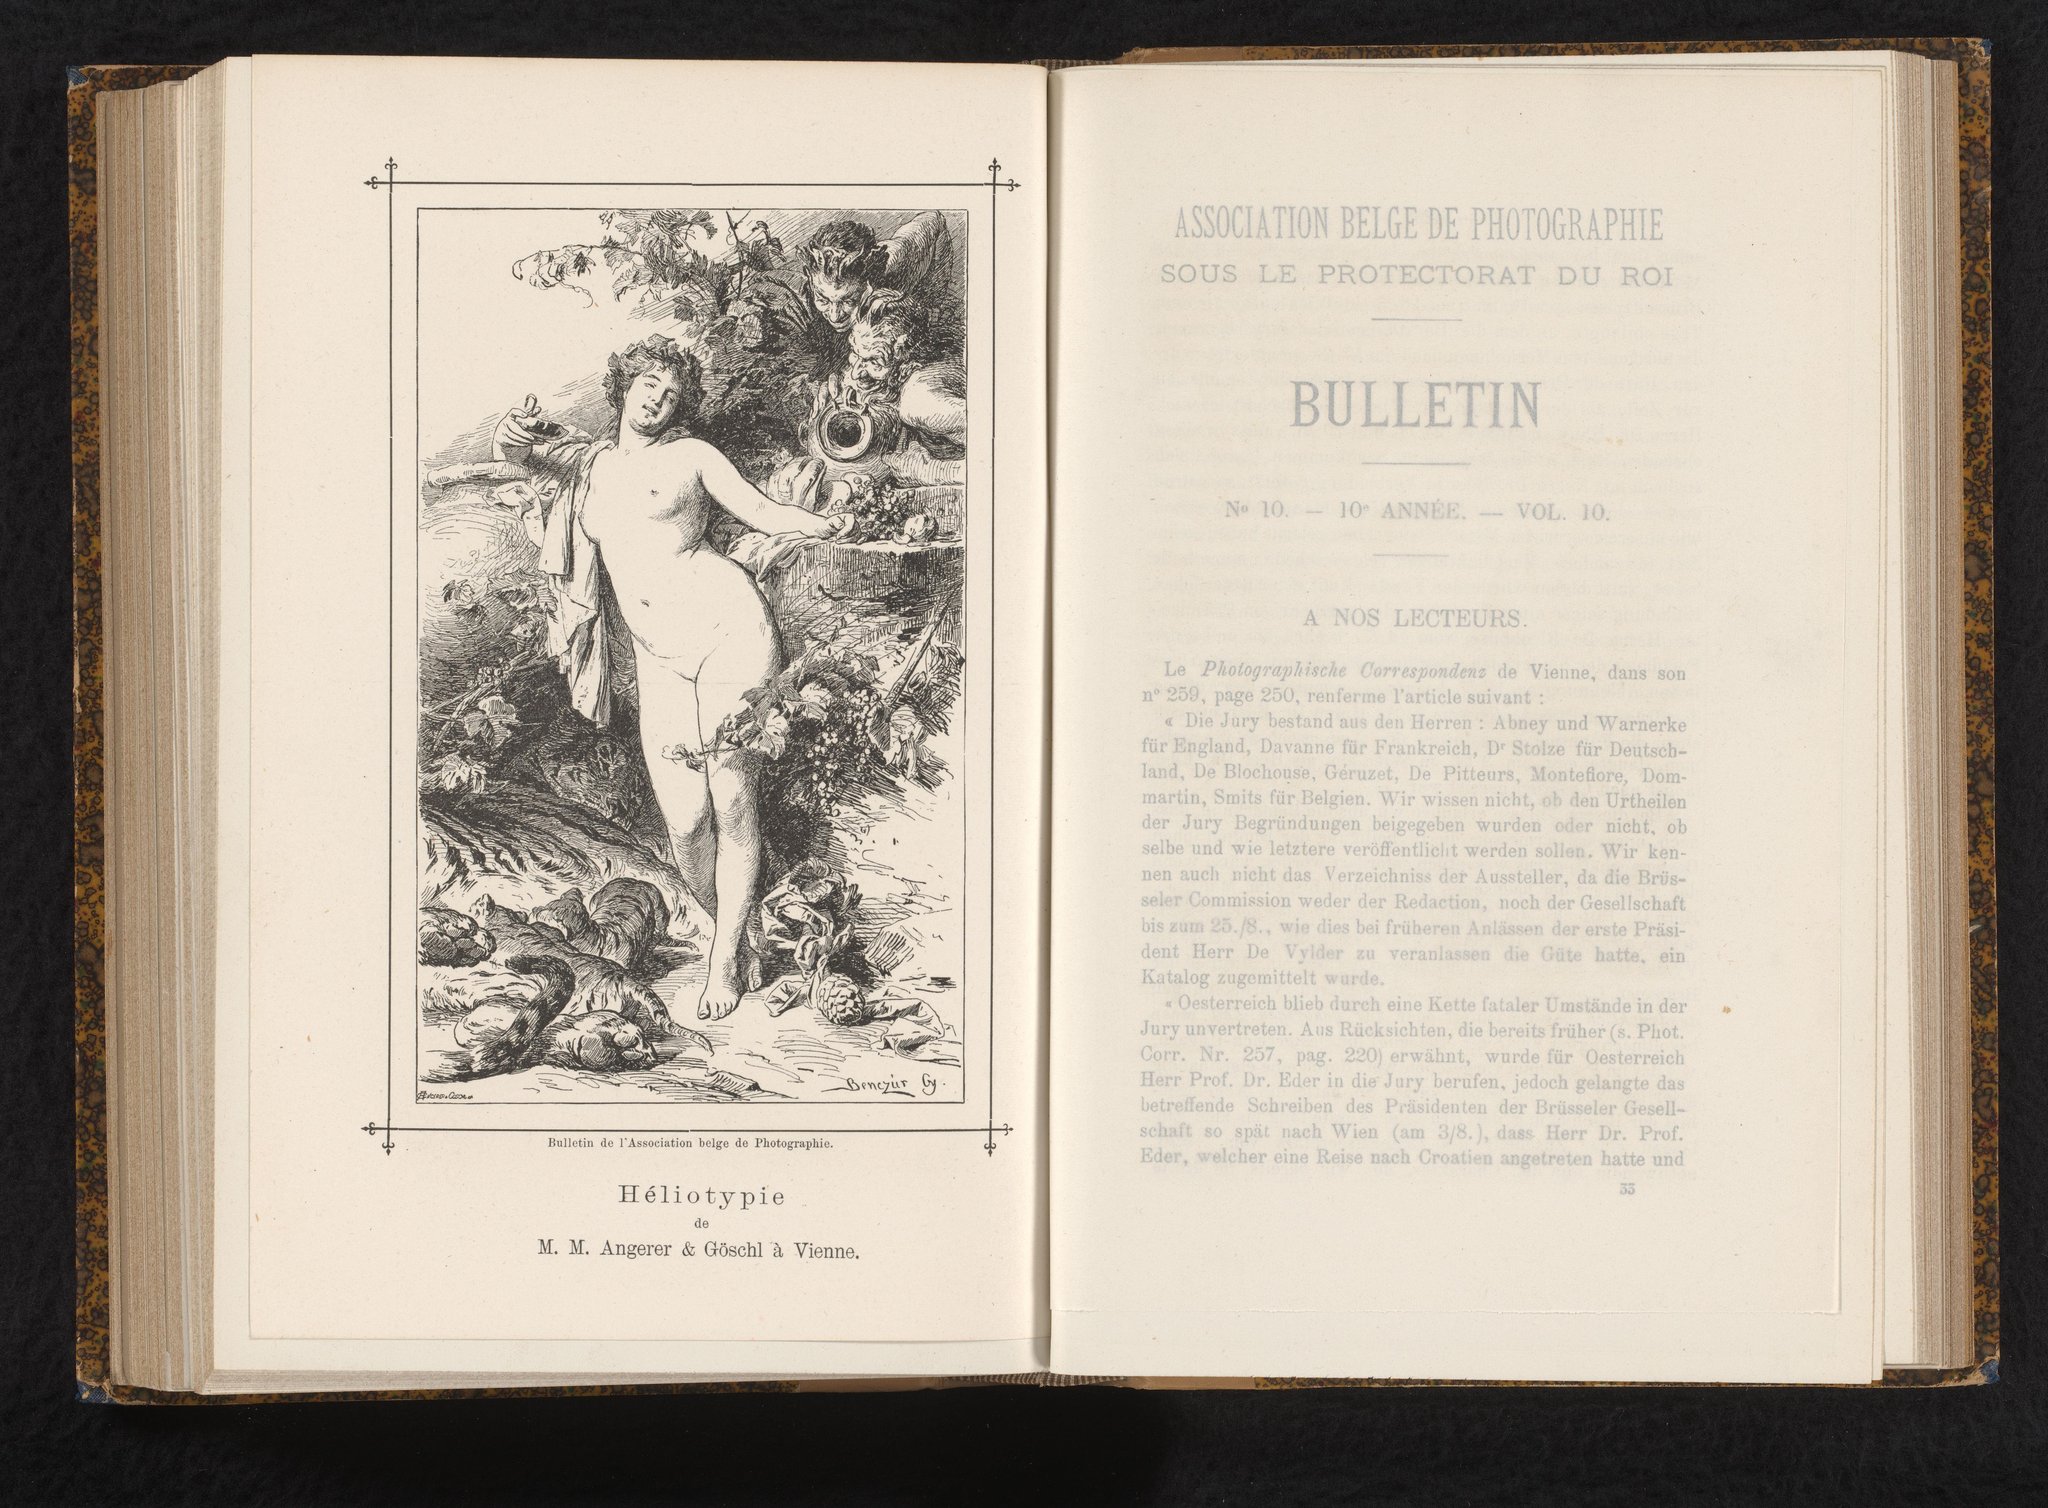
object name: page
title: Reproductie van een prent van een naakte vrouw met satyrs door Gyula Benczúr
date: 1878-1883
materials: paper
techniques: heliotype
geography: vienna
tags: maenad(s), female bacchant(es), satyr(s) spying upon